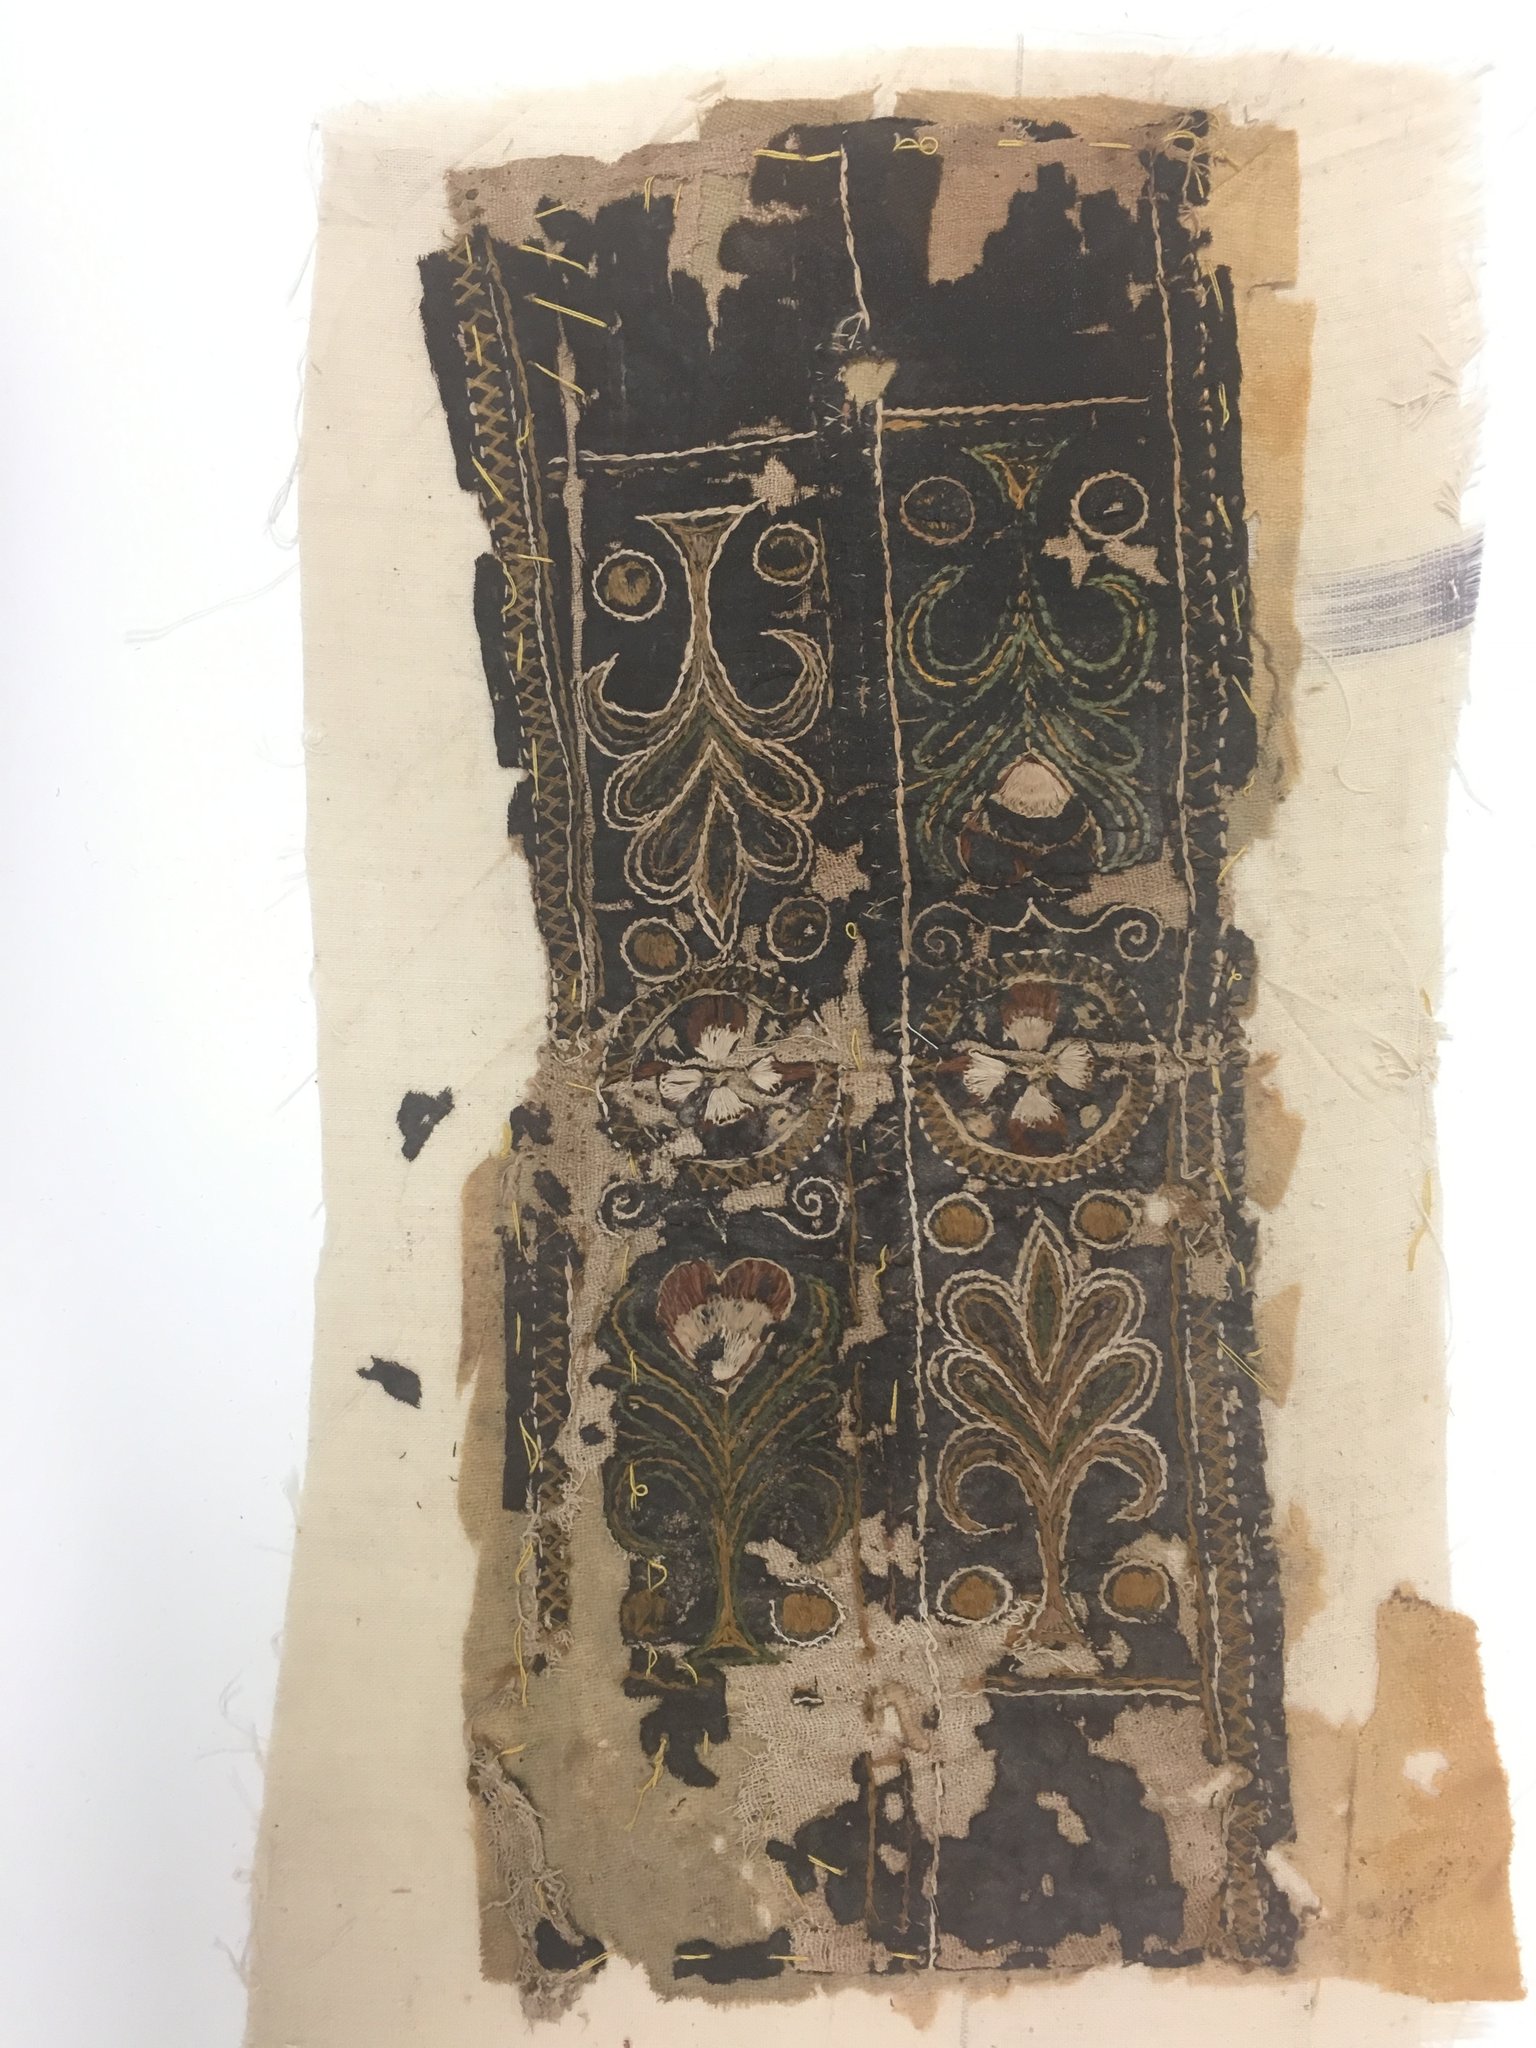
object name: panel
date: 501-700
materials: silk, wool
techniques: embroidery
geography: egypt